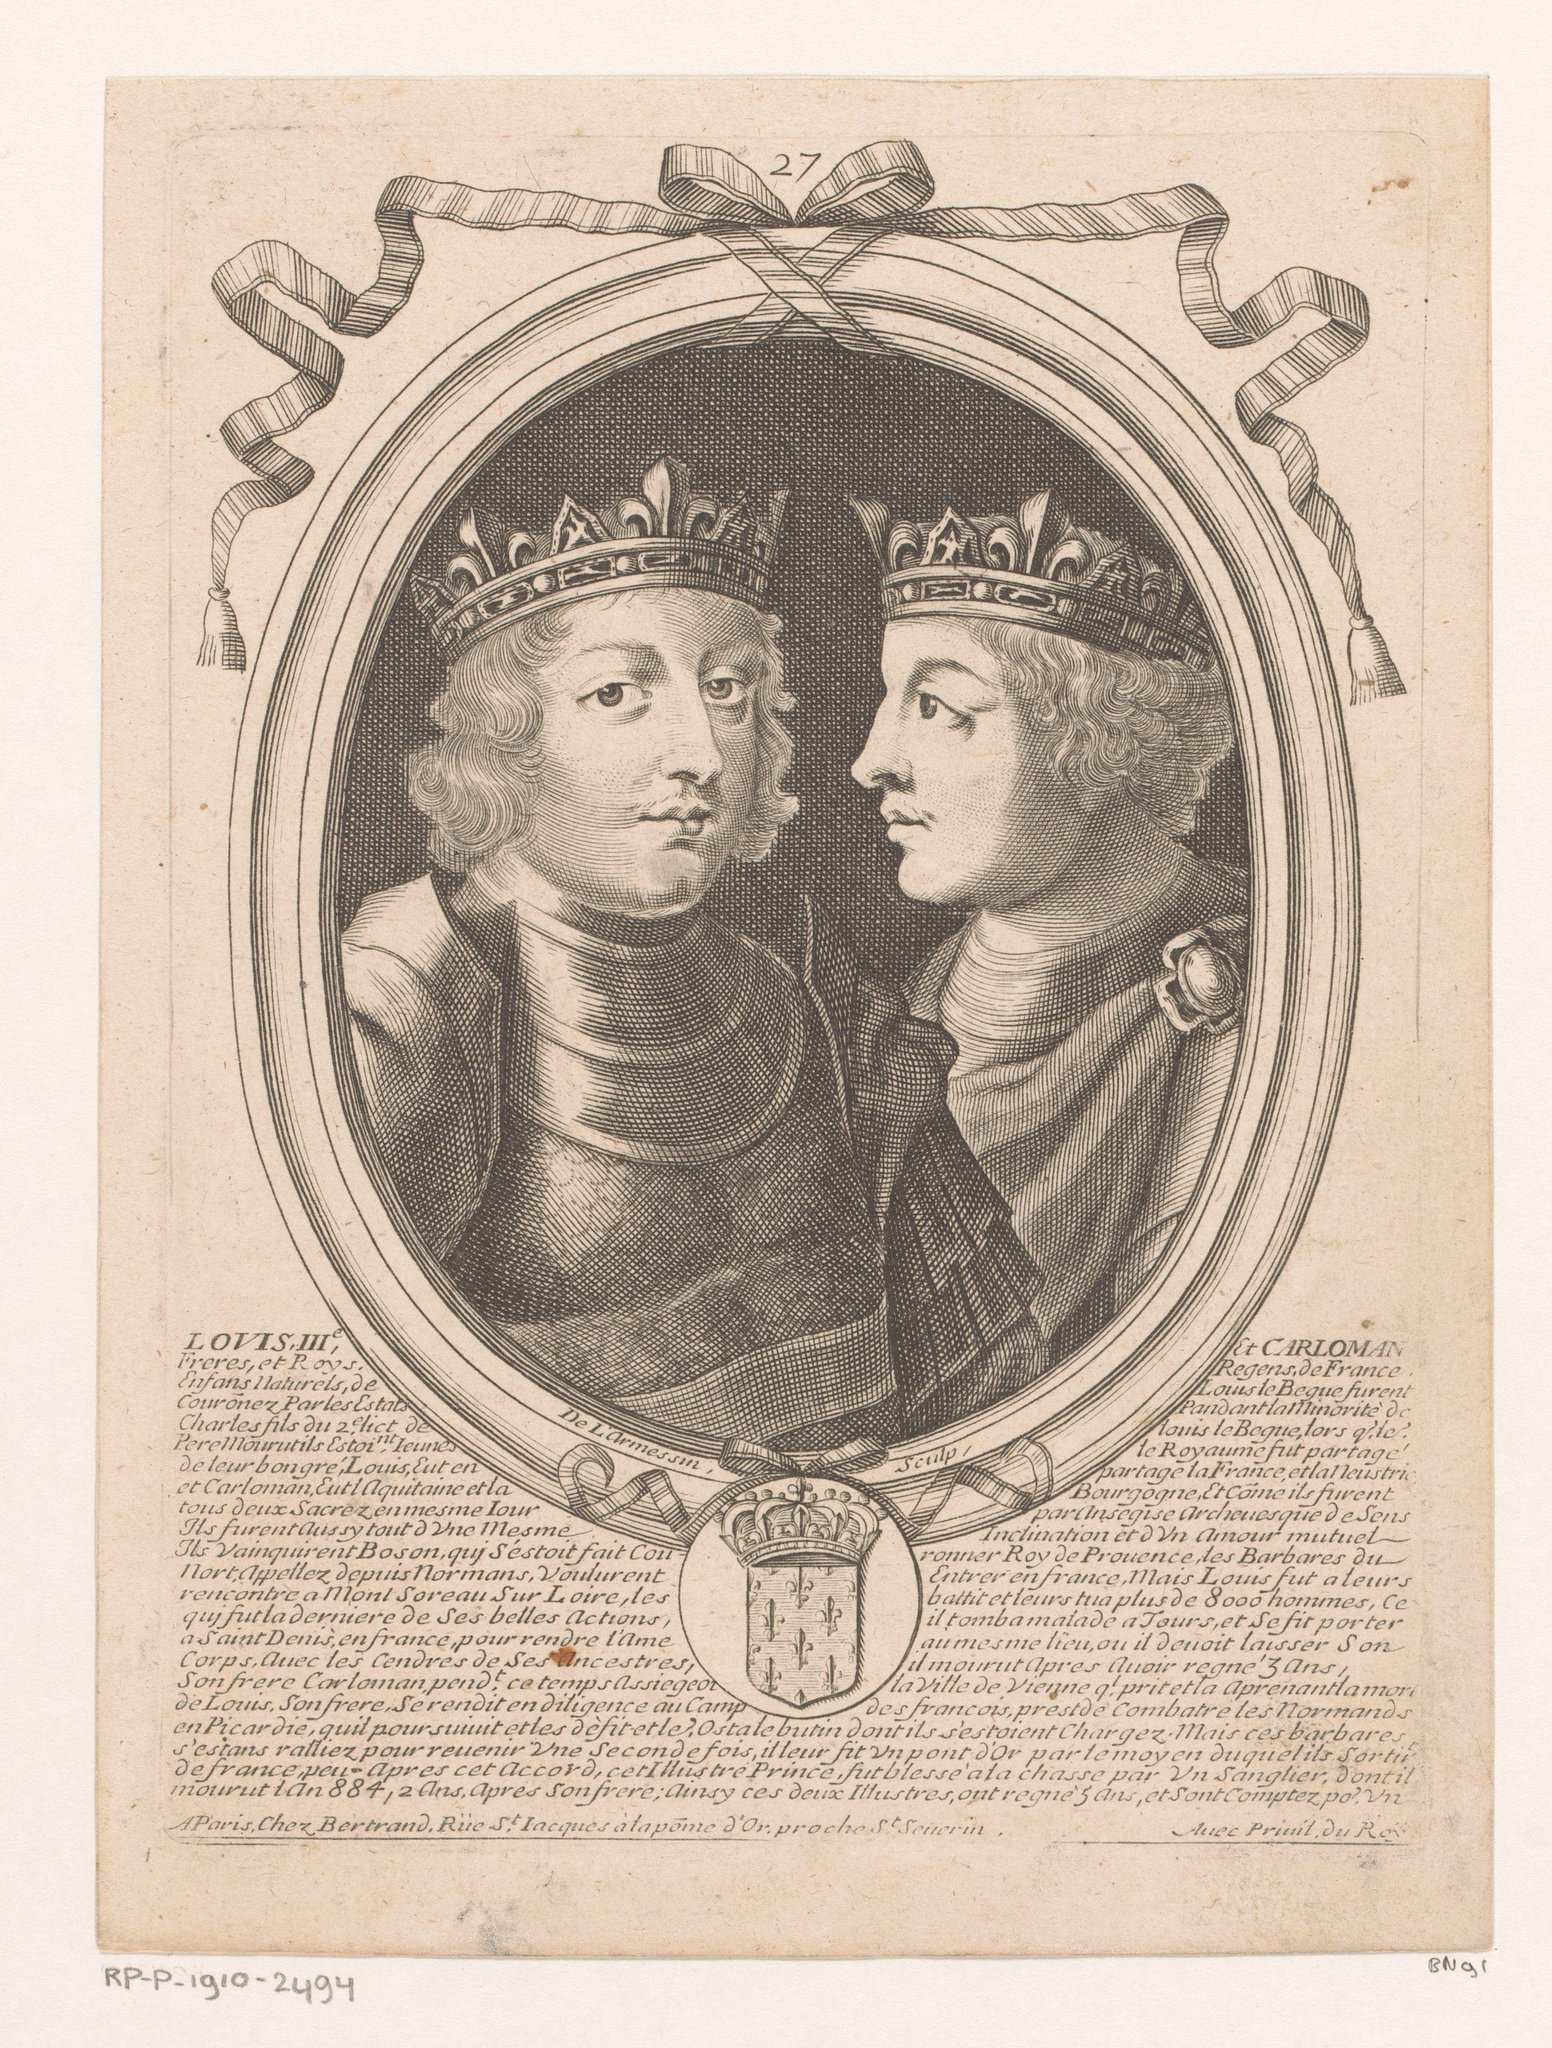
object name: print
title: Portretten van prominente figuren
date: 1647-1678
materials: paper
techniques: engraving, etching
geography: france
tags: historical persons, king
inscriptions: collector's mark: Lugt 2228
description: Maakt deel uit van een grootschalige serie met portretten van prominente figuren. Binnen de serie bevindt zich een sectie getiteld 'Les Augustes Représentations De tous les Roys De France depuis Pharamond Iusqu'à Louys XIIII'. De serie werd respectievelijk uitgegeven door Pierre Bertrand, door zijn weduwe en door De Larmessin zelf.